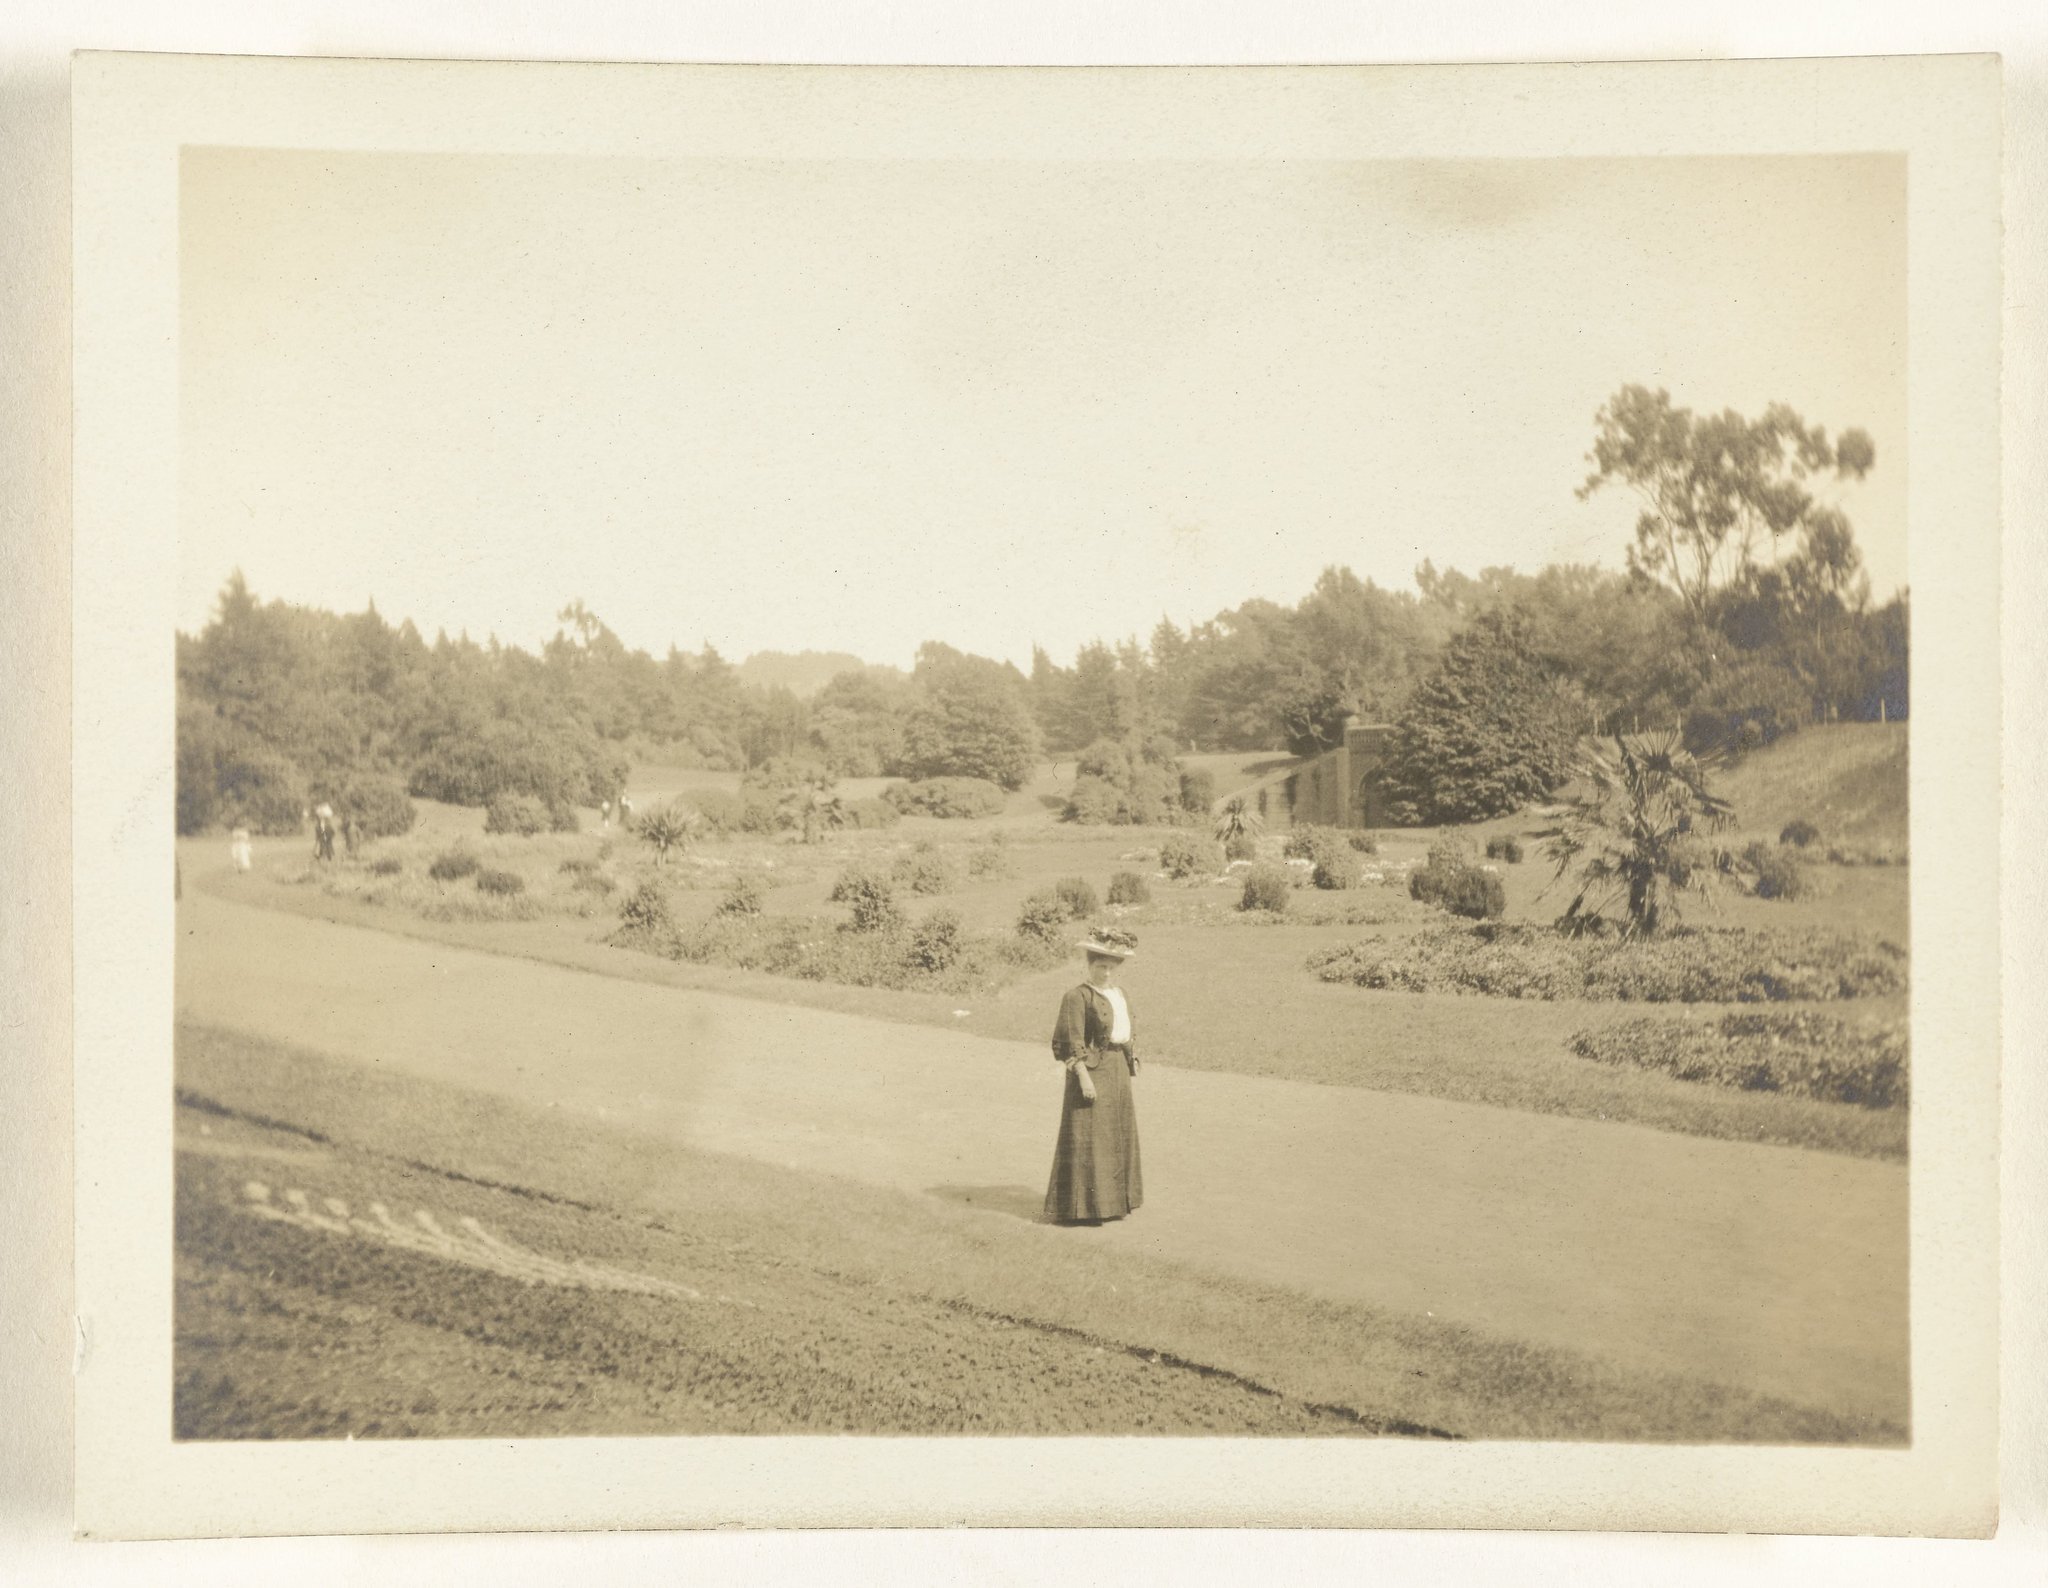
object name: photograph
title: The golden gate park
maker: geldolph adriaan kessler (dolph)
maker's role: fotograaf, industrieel, voetballer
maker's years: 1884-1945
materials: cardboard, photographic support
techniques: gelatin silver print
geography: san francisco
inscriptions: title: ‘In the golden gate park’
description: Vermoedelijk mevrouw Deterding wandelt door het Golden Gate Park in San Francisco.Onderdeel van het fotoalbum van Dolph Kessler met opnamen die hij maakte tijdens zijn verblijf in Engeland en op een wereldreis die hij als secretaris van Henri Deterding (directeur Koninklijke Olie) ondernam naar Nederlands-Indië, Japan, China en de Verenigde Staten, tussen 1906 en 1908.